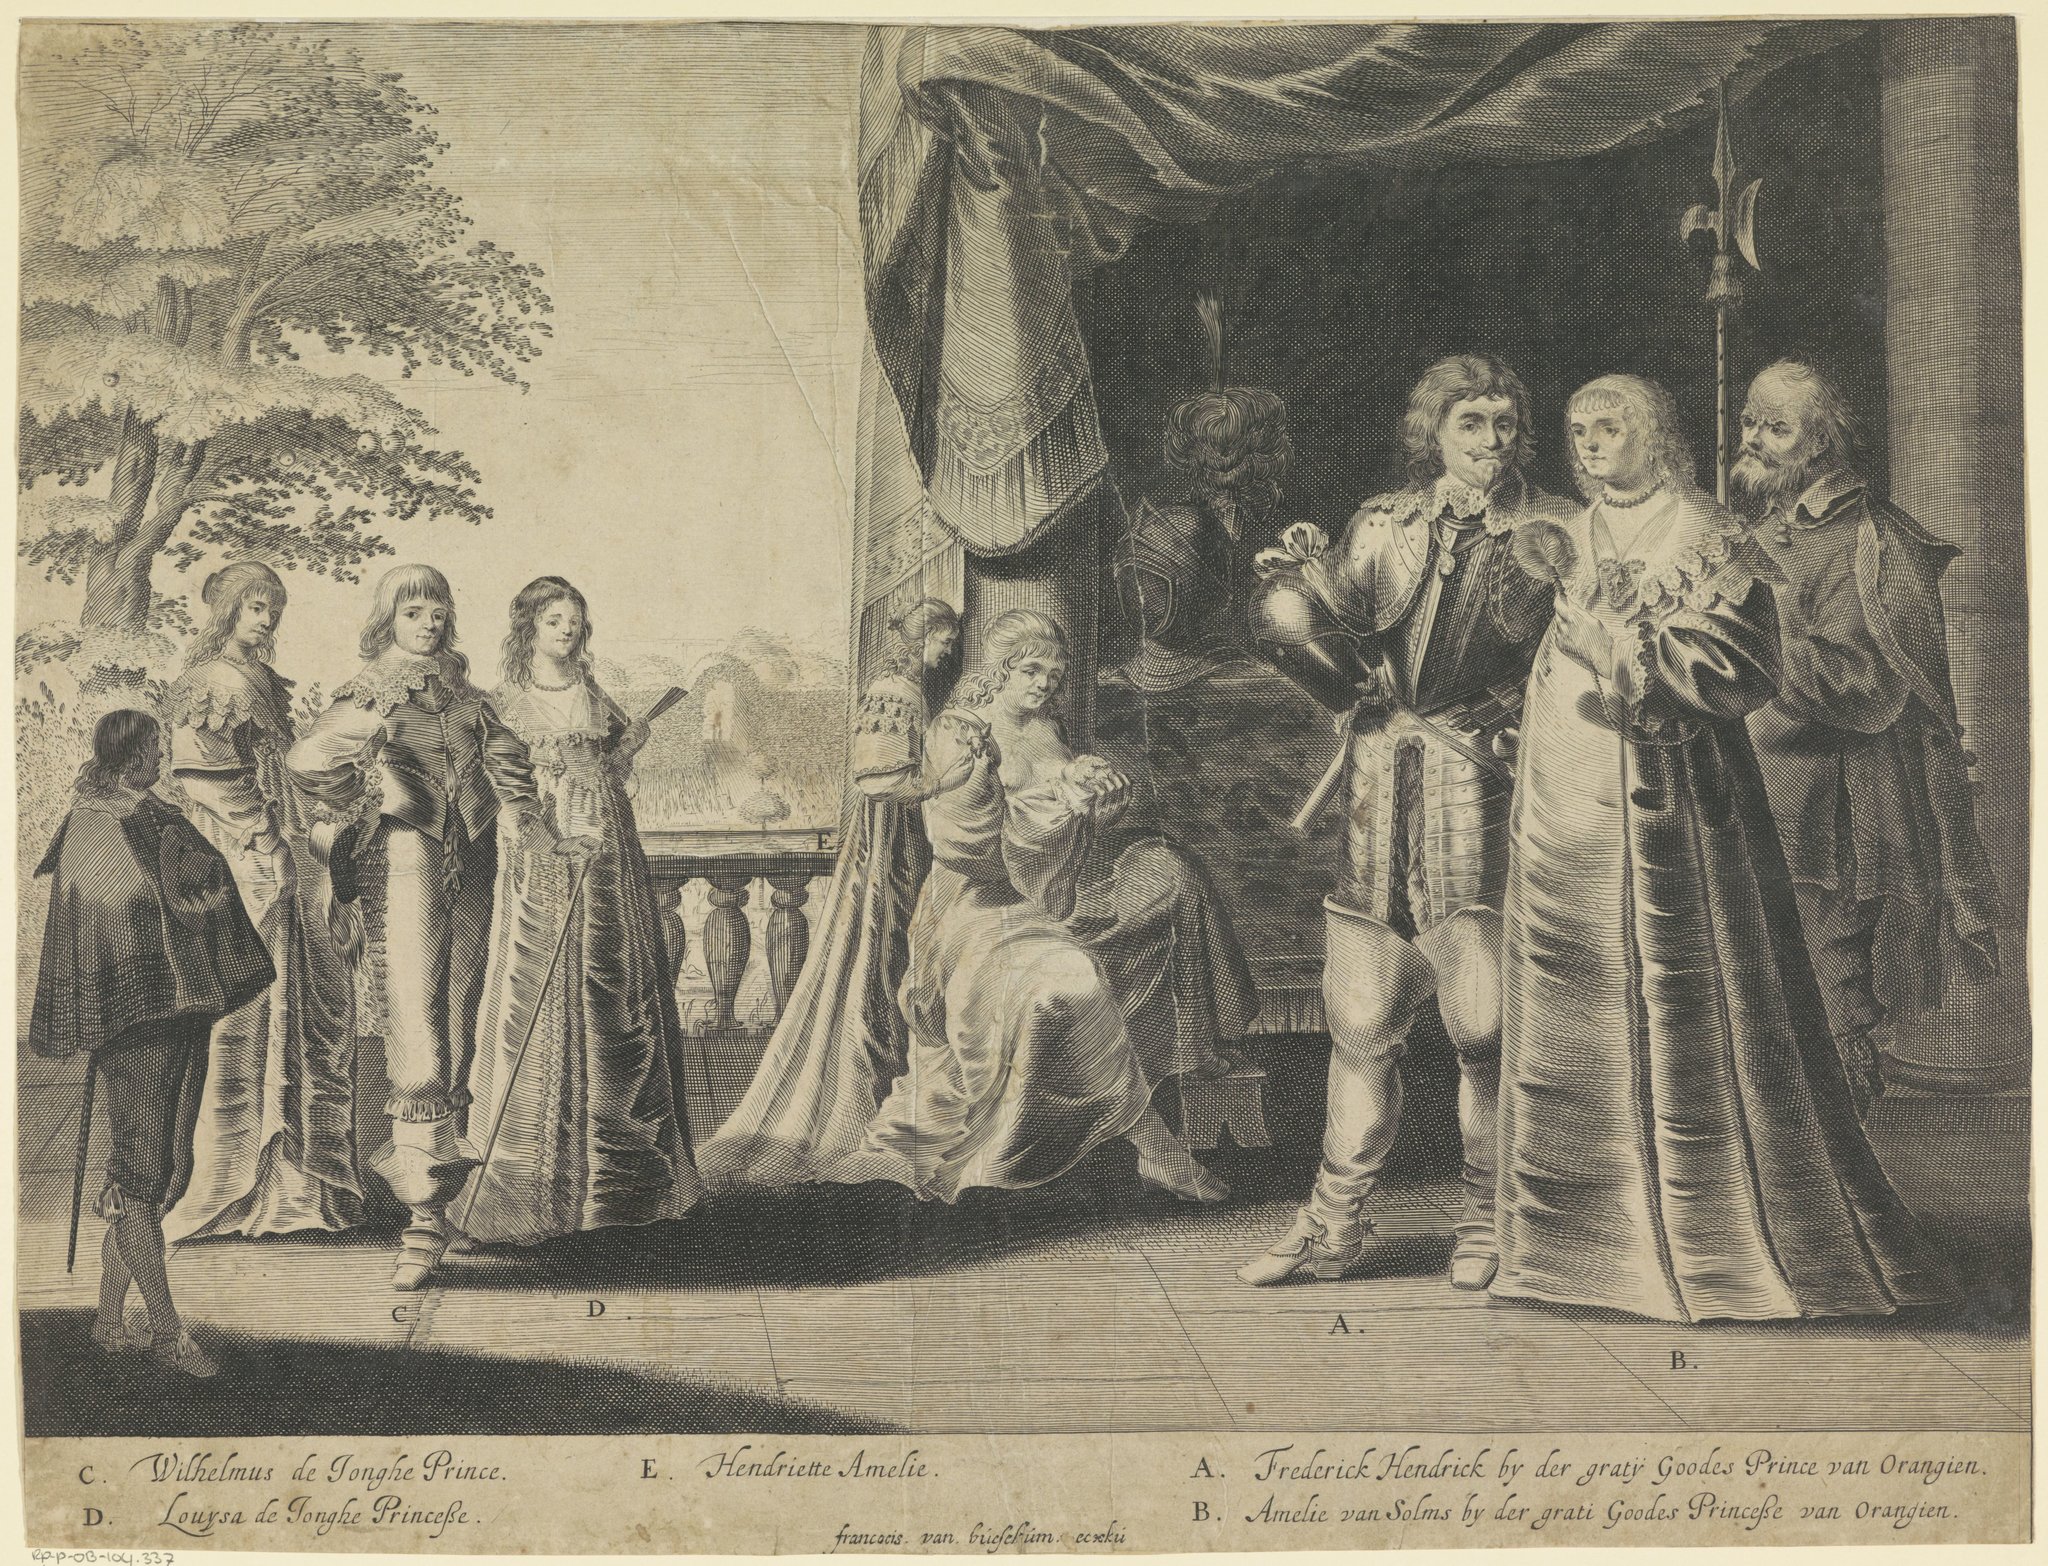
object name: print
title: Familieportret van Frederik Hendrik, prins van Oranje, Amalia van Solms en hun kinderen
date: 1642-1665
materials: paper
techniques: engraving, etching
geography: low countries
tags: frederick henry (prince of orange), william ii (prince of orange), the hague, amalia of solms-braunfels, berlin, louise henriëtte (prinses van oranje), knighthood order (garter) - insignia of a knighthood order, e.g.: badge, chain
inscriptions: collector's mark: Lugt 963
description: Familieportret van Frederik Hendrik, Amalia en hun kinderen Willem II, Louise Henriëtte en Henriëtte Amalia. De groep staat op een balkon, op de achtergrond een tuin. In de ondermarge hun namen.